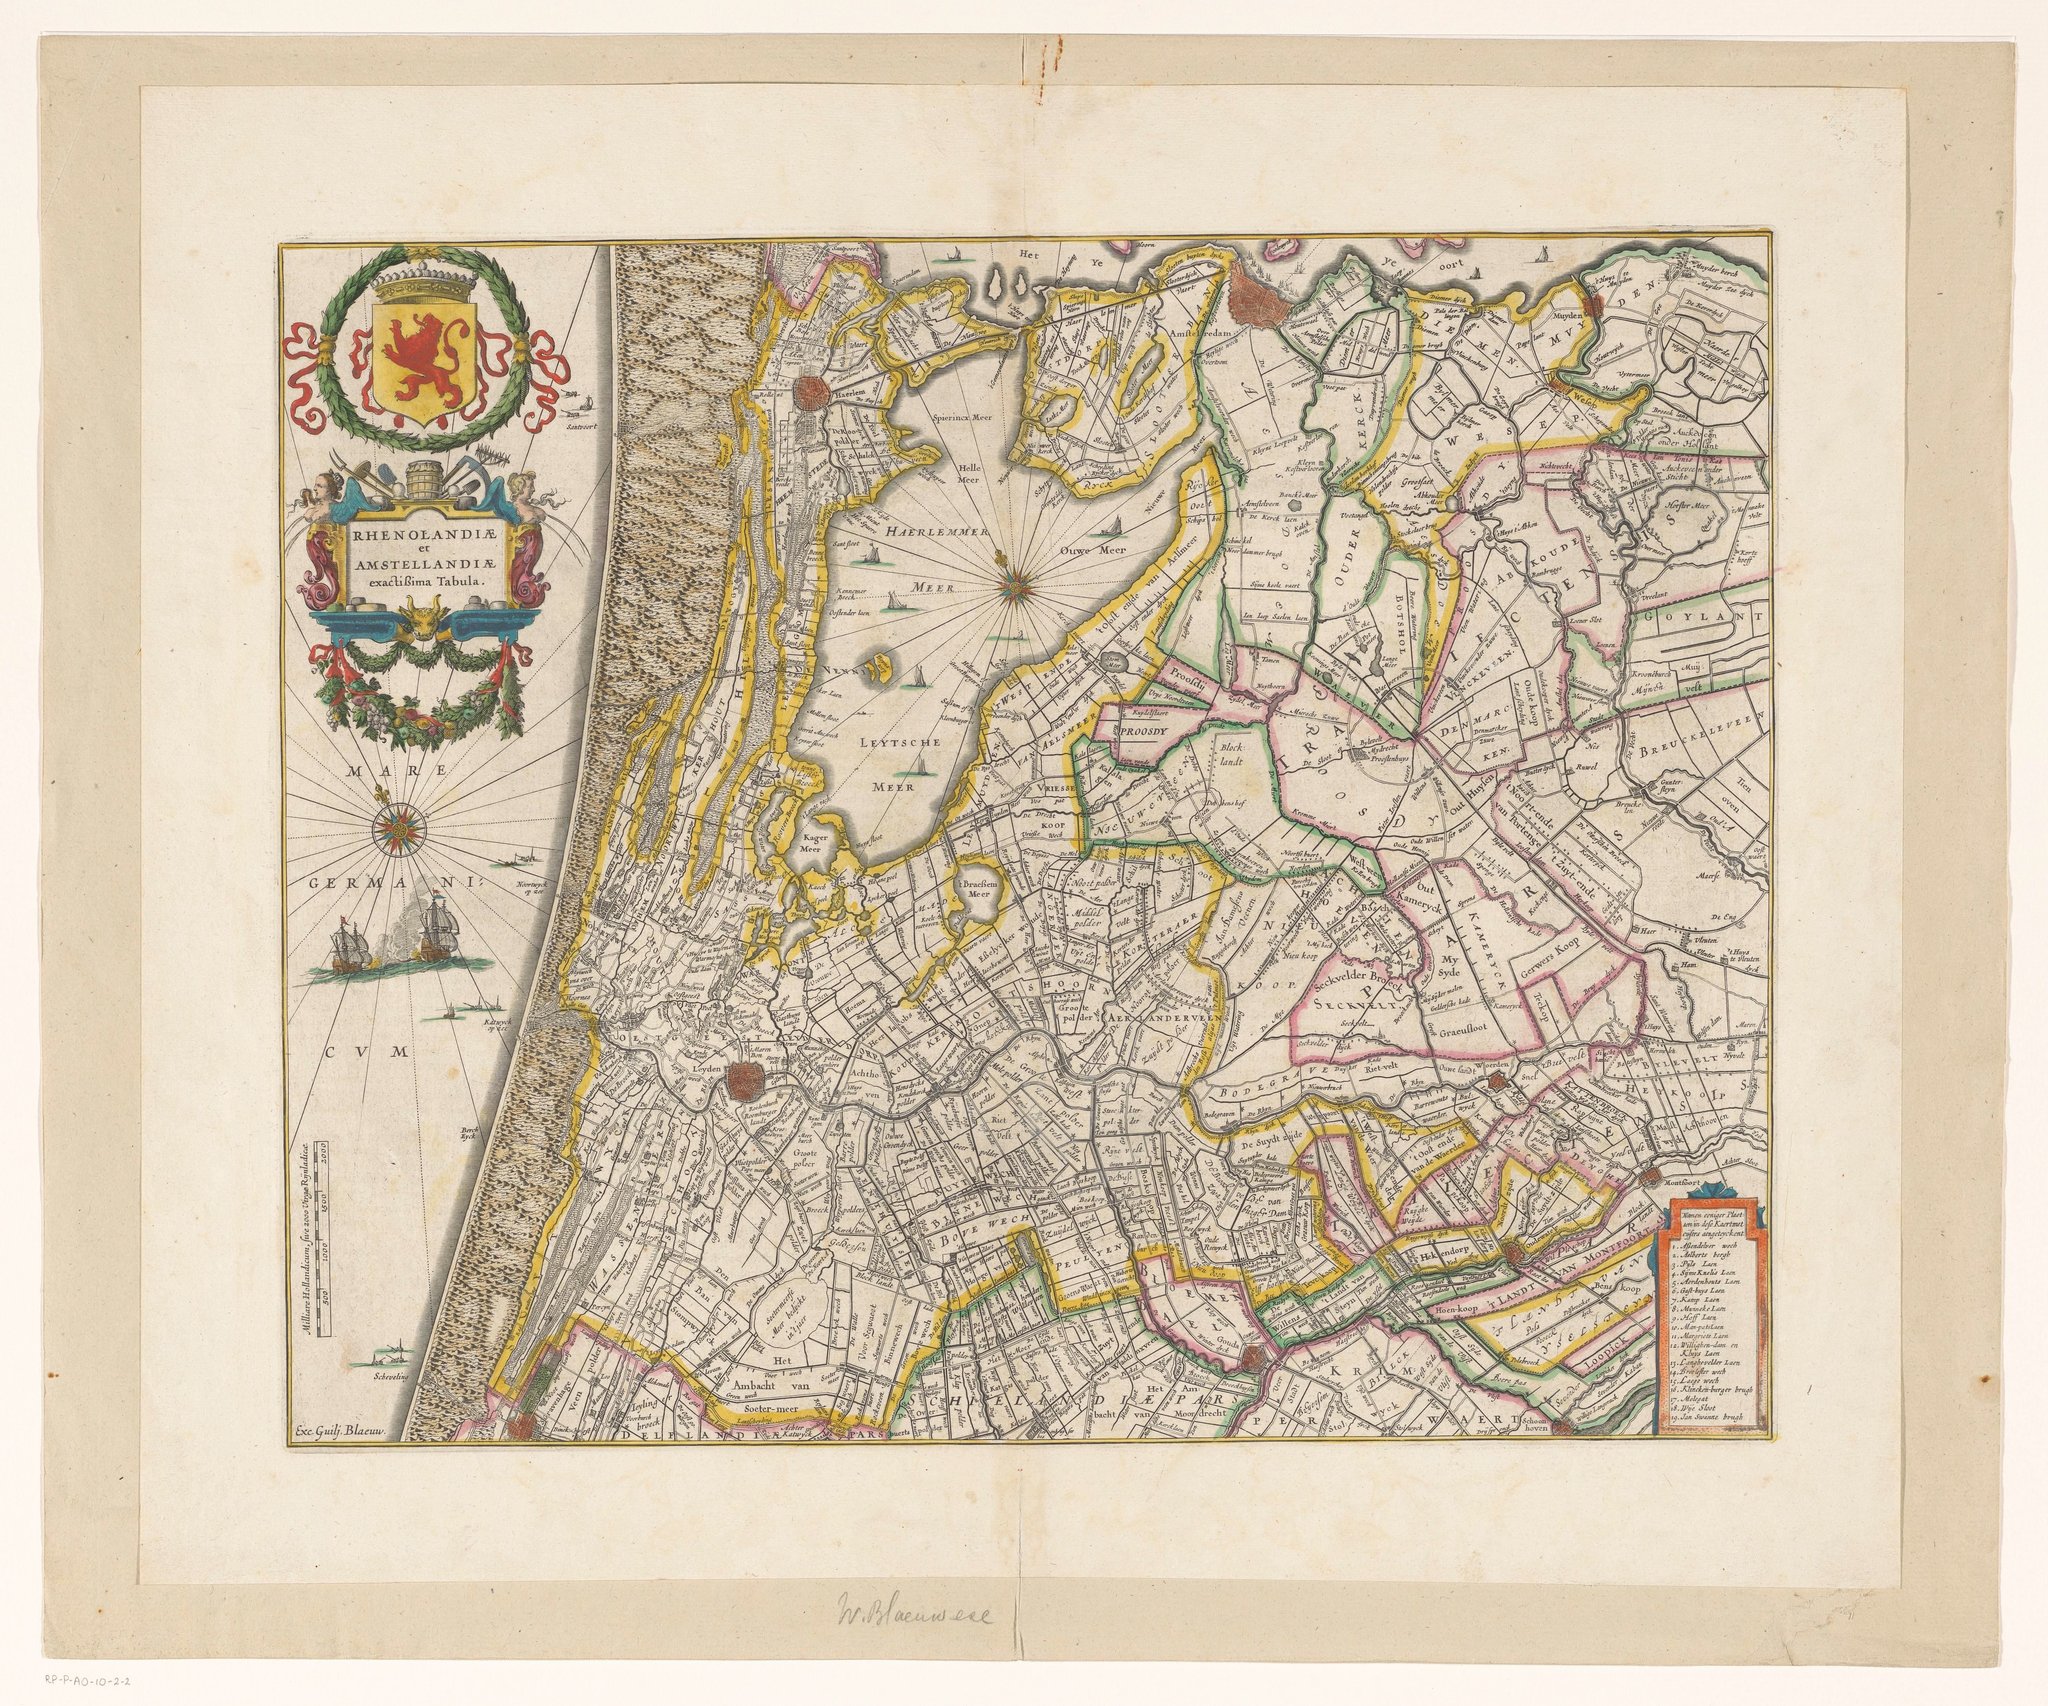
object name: map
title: Kaart van Rijnland en Amstelland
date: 1647-1664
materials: paper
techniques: engraving, hand coloring, letterpress printing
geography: amsterdam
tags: maps of separate countries or regions, coat of arms (as symbol of the state, etc.) (+ province; provincial), holland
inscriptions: collector's mark: Lugt 2228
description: Prent met Nederlandse tekst op verso ook gebruikt in: Blaeu, Willem Janszoon en Johannes Willemszoon Blaeu. Toonneel des aerdrycx, ofte nieuwe Atlas, dat is de beschryving van alle landen. 4 delen. Amsterdam: Johannes Willemszoon Blaeu, 1647-1650, dl. 1 (1647-1648). En in daaropvolgende Nederlandstalige atlassen van Blaeu (1649-1650, 1658-1661 en 1664).